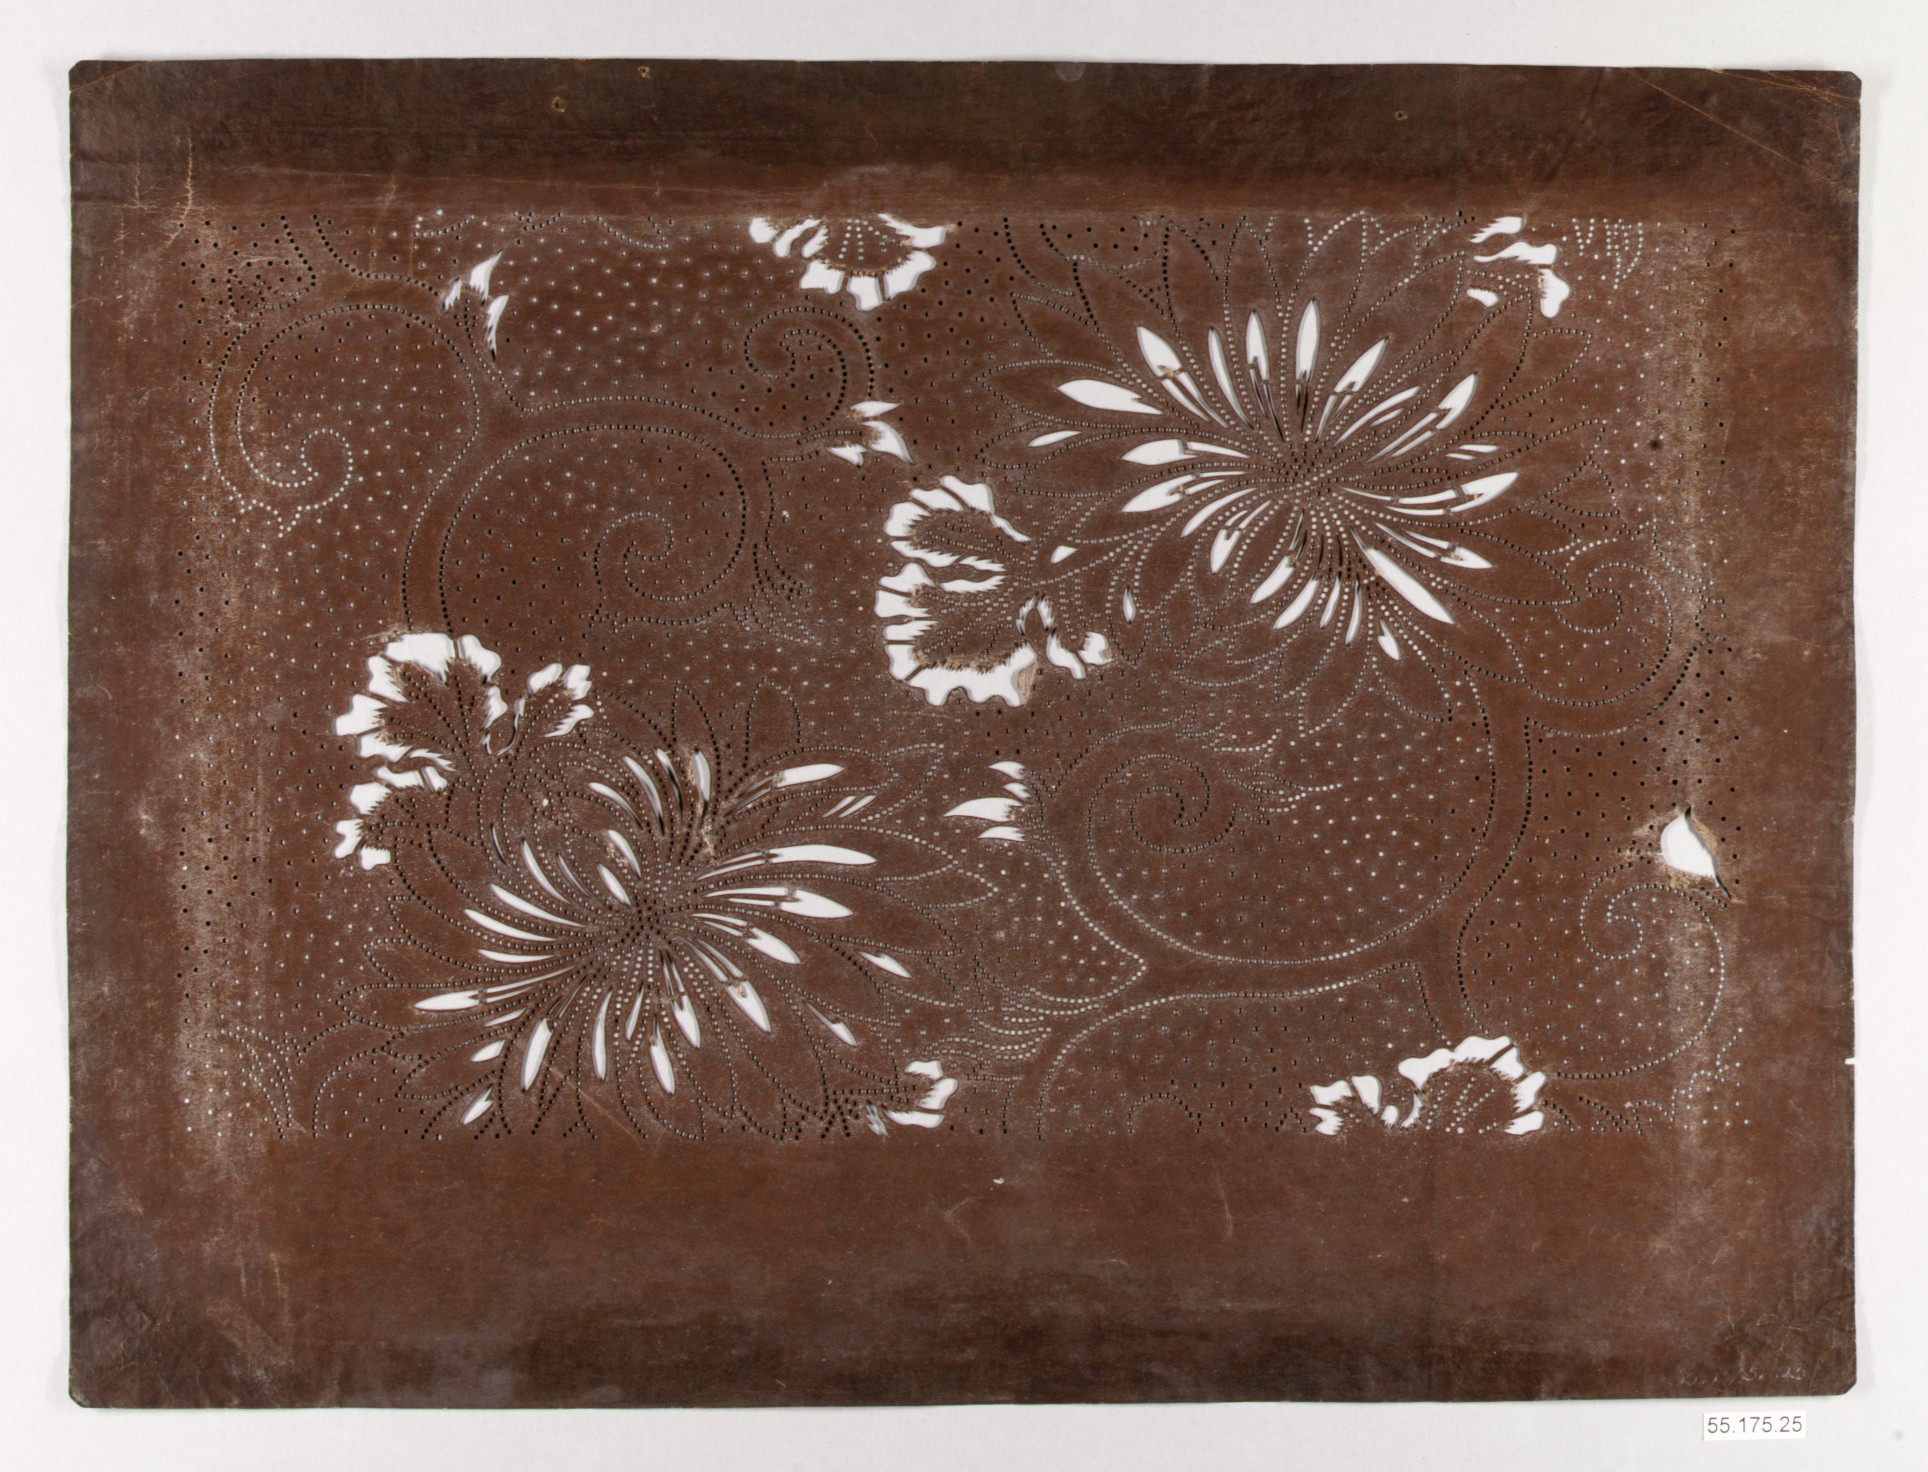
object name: stencil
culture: japanese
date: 1801-1900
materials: paper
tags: flowers